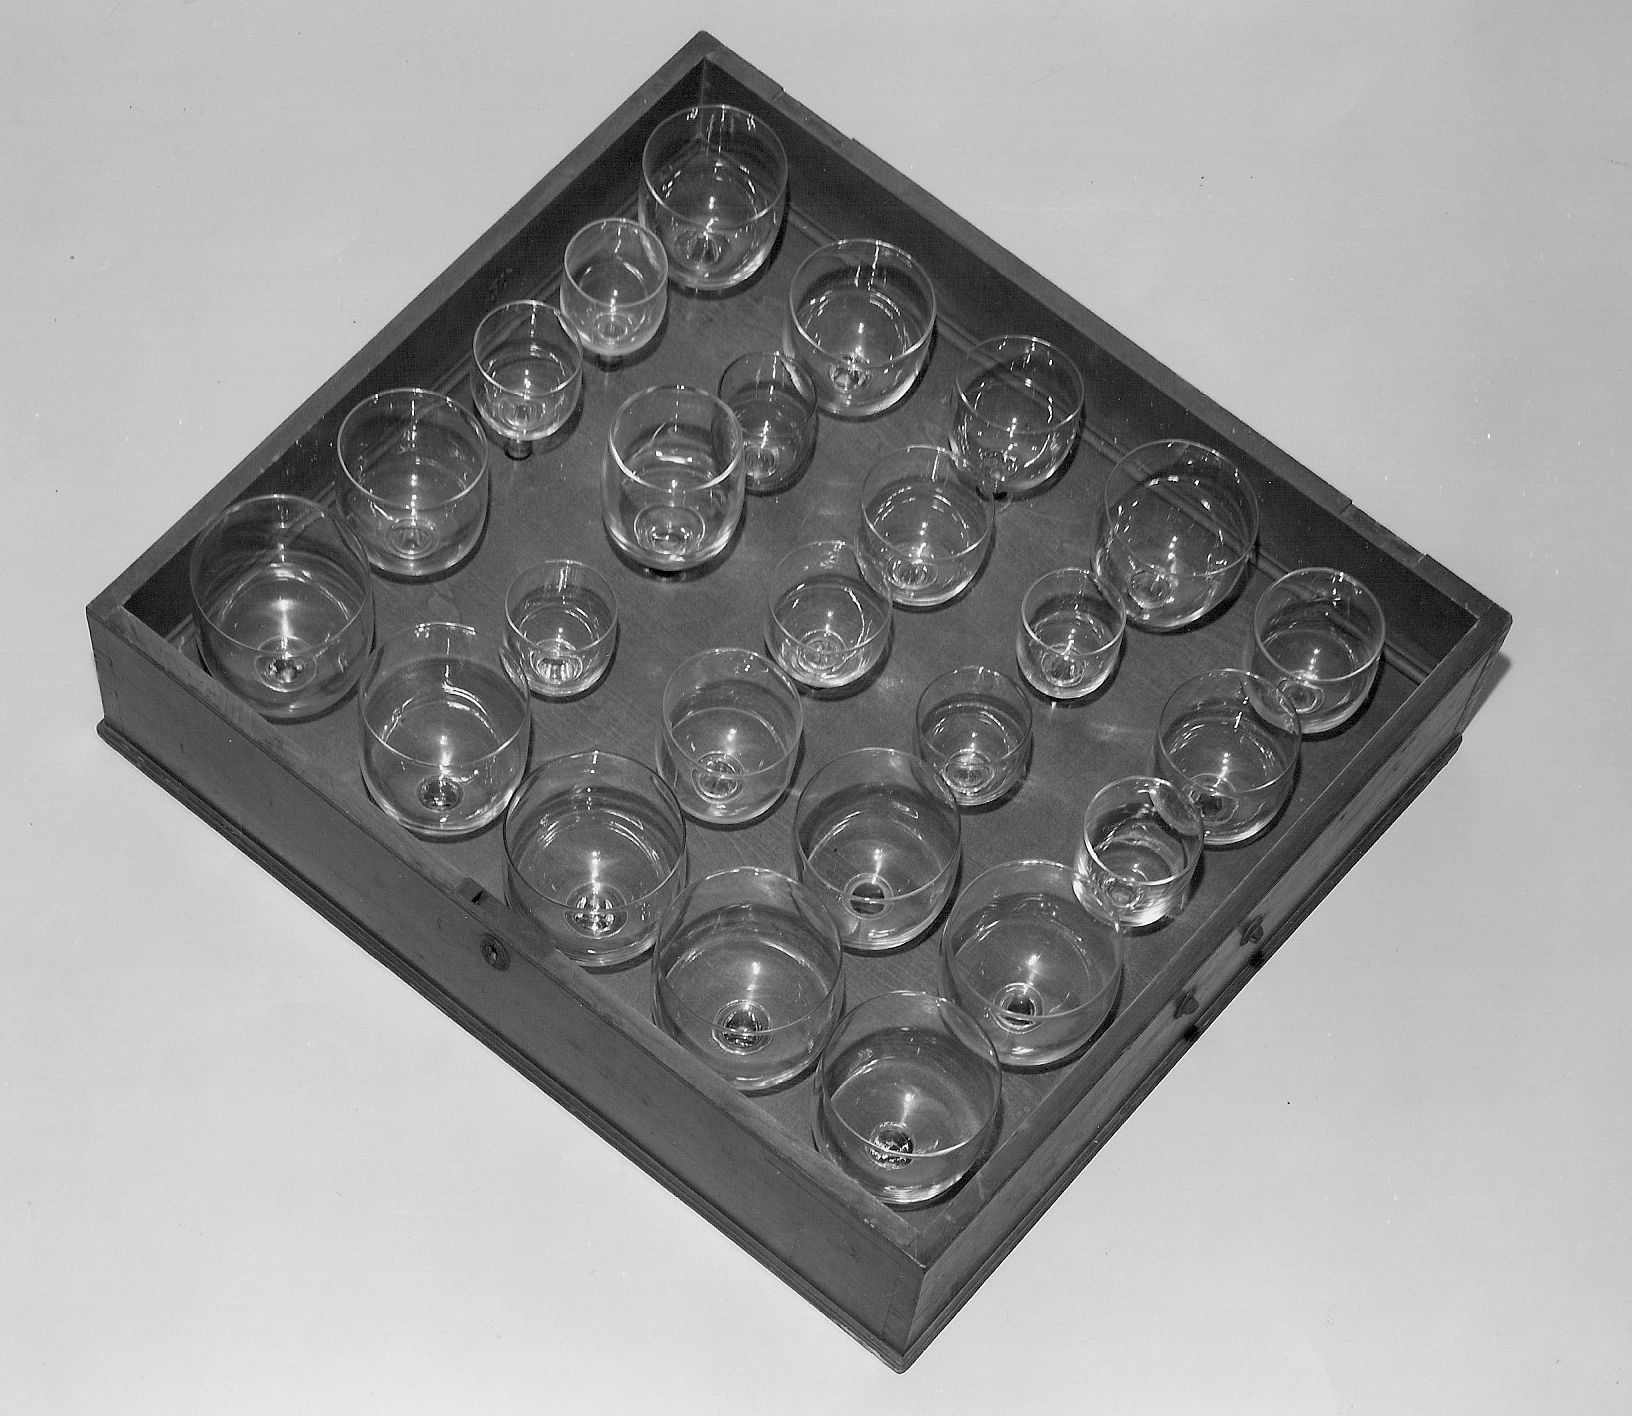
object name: musical glass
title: Musical Glasses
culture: american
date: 1825-1889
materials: wood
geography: united states